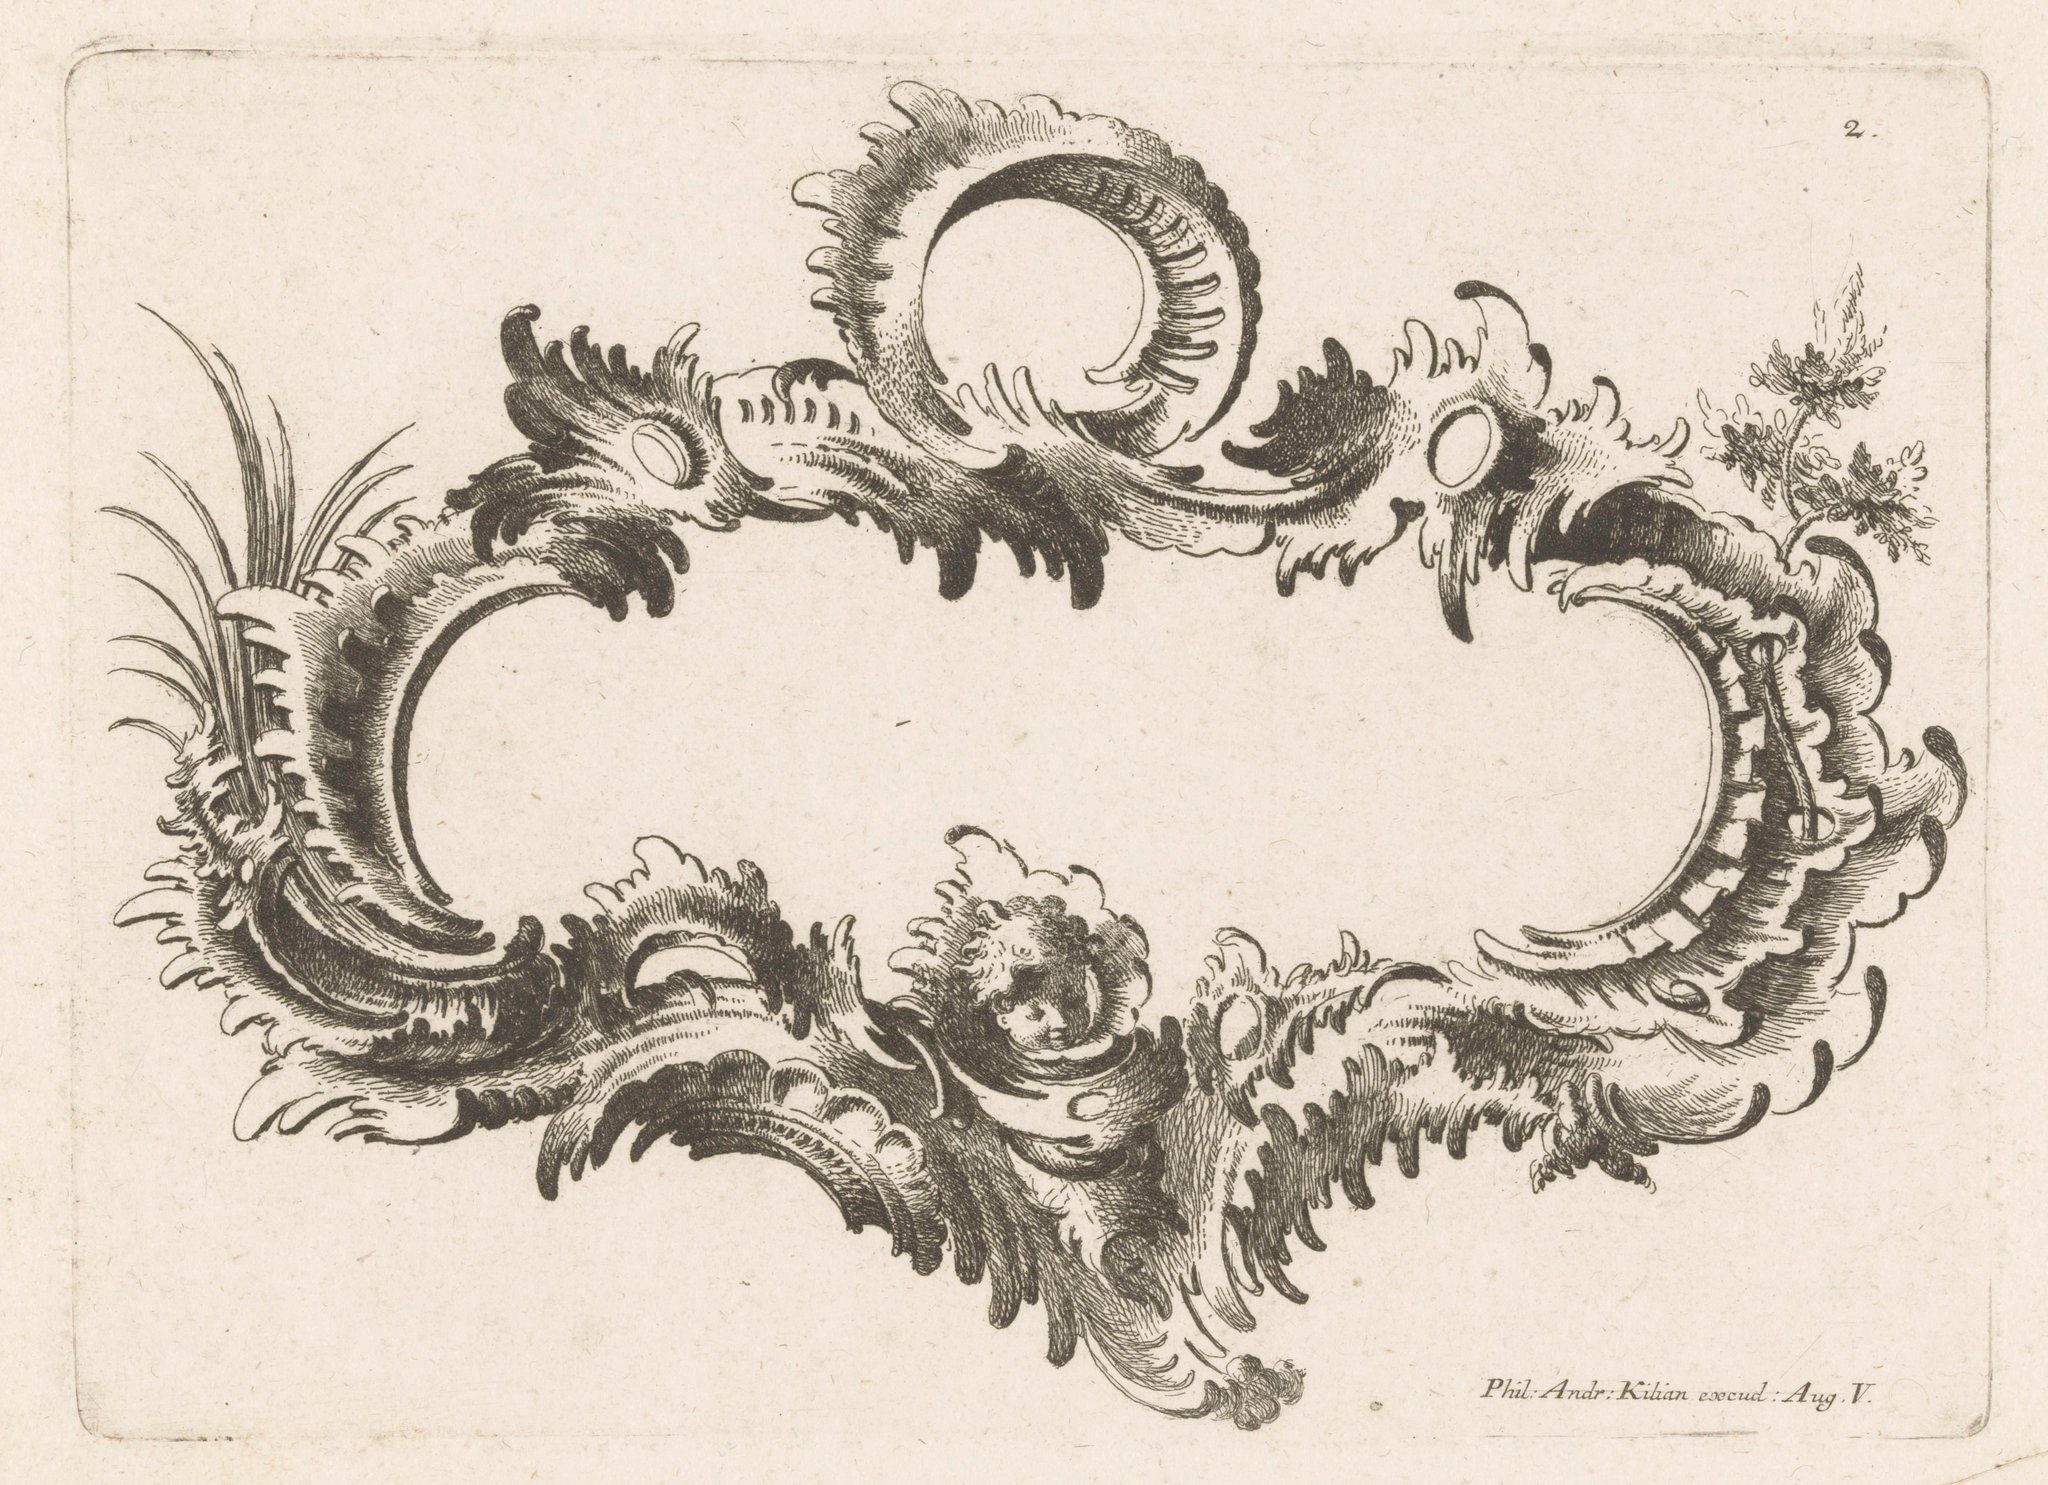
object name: ornament print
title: Cartouches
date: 1747-1759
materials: paper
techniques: etching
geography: augsburg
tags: ornament ~ cartouche, cupids: 'amores', 'amoretti', 'putti'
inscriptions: collector's mark: Lugt 2228, collector's mark: Lugt 2760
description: Rocaille cartouche met bladmotieven en hoofd van een putto.